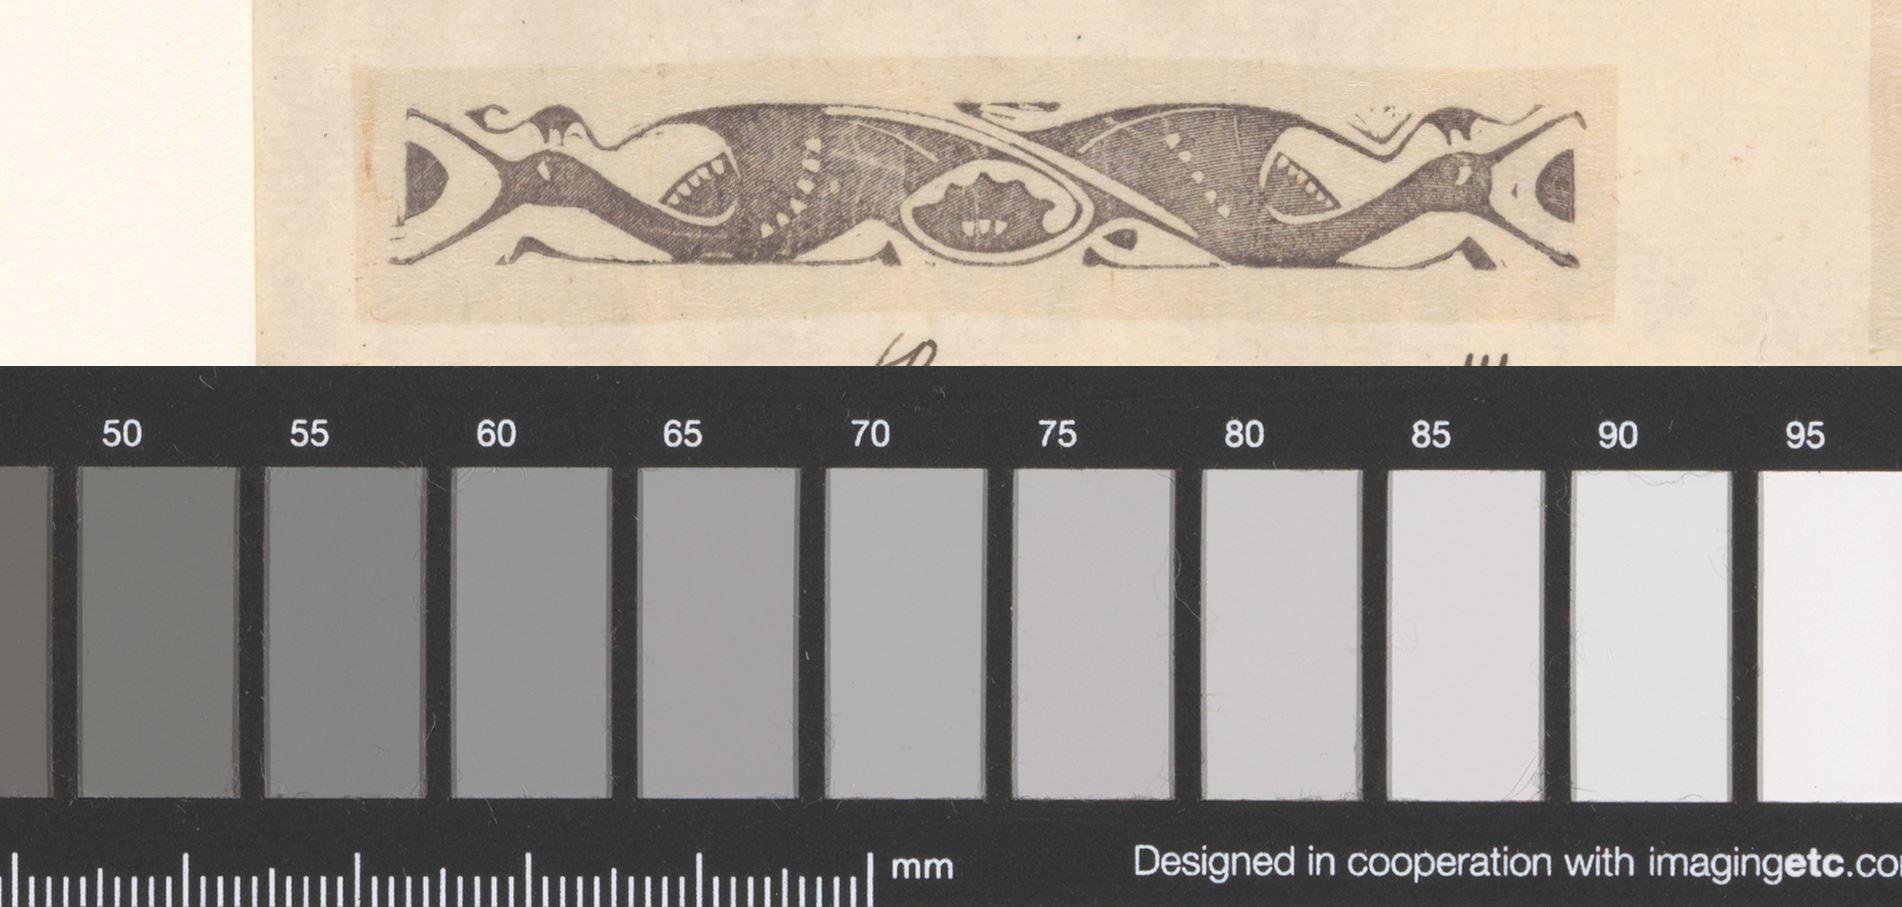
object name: print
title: Twee vogels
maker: karel petrus cornelis de bazel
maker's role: draughtsman, print maker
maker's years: 1869-1923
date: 1896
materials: paper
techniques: woodcut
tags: birds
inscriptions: number: ‘10 III’, collector's mark: Lugt 2228